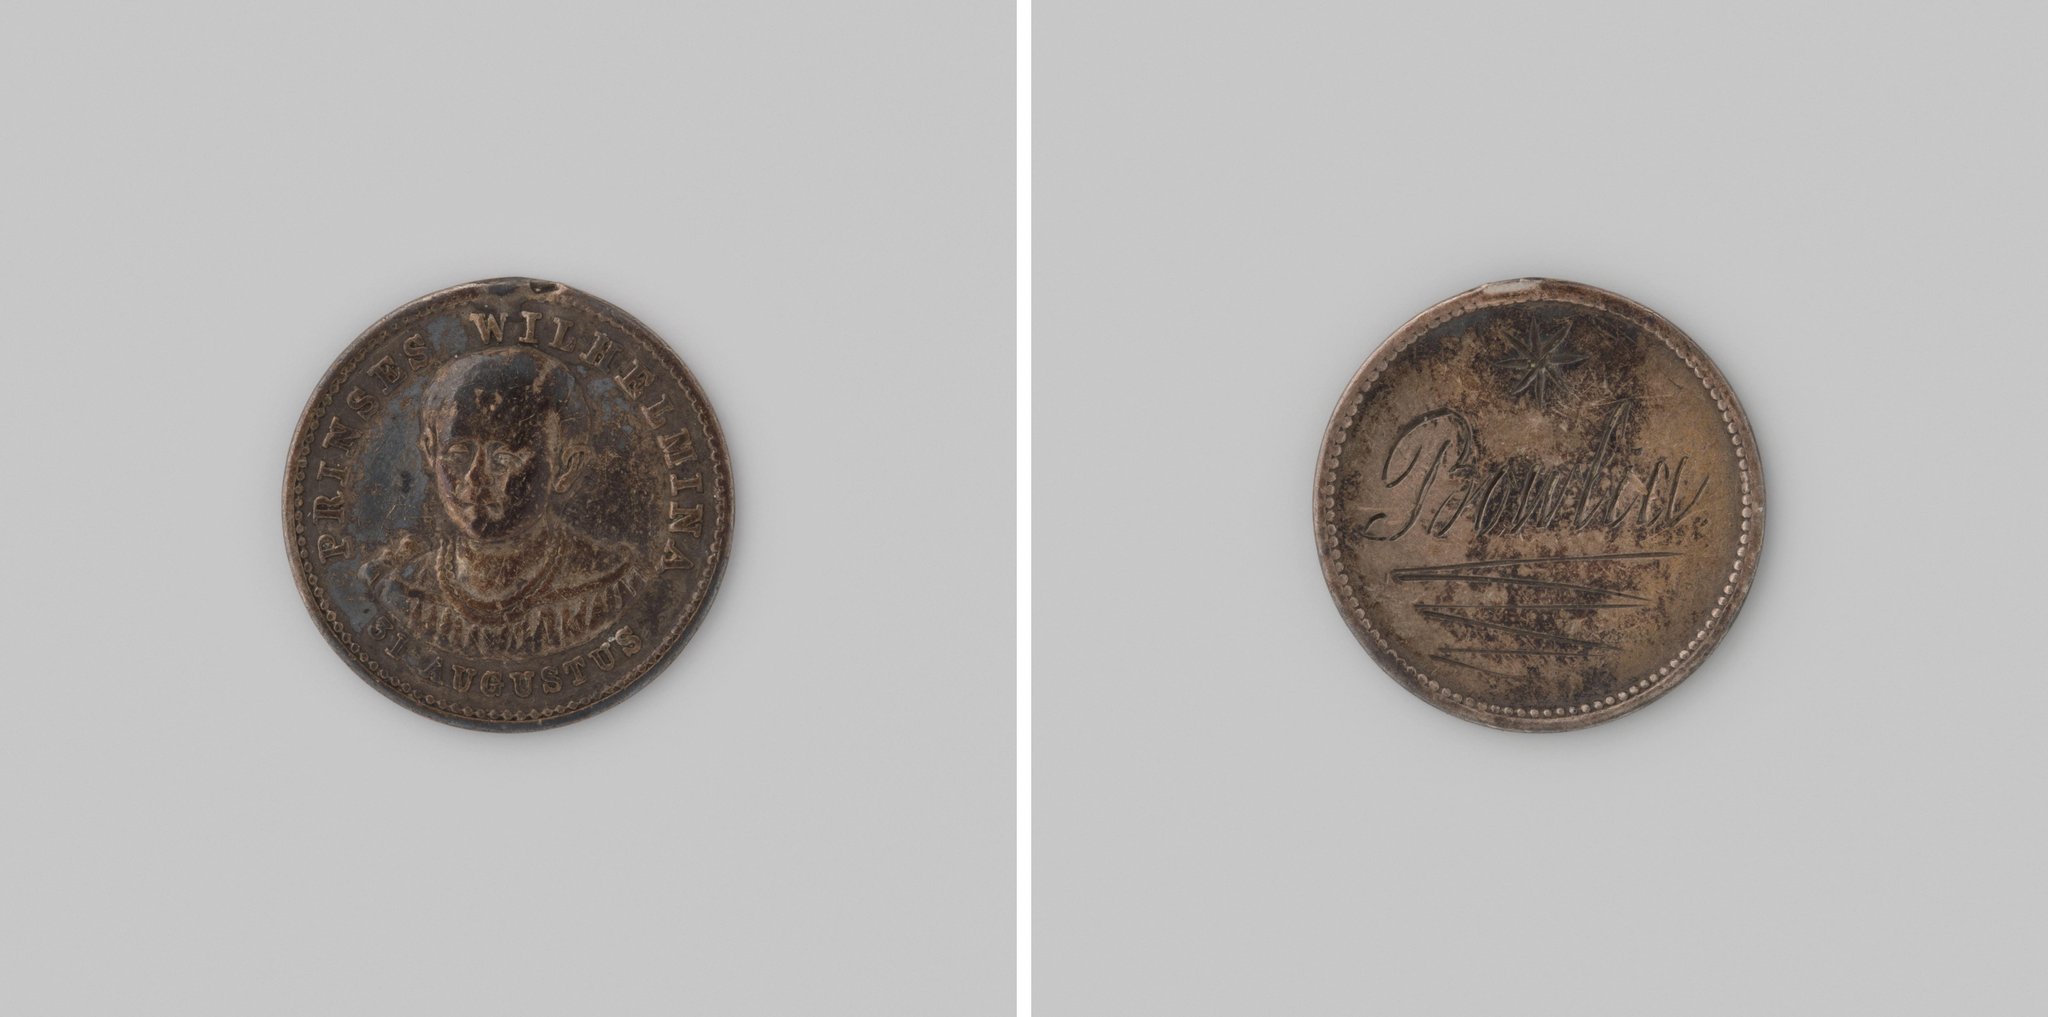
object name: history medal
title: Draagpenning op de vijfde verjaardag van Prinses Wilhelmina (1885) met inscriptie Bowlia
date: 1890-1898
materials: silver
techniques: engraving, striking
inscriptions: inscription: ‘(ster) / Bowlia. / (lijnen)’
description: Zilveren penning met verwijderd draagoog, op de voorzijde het borstbeeld van Wilhelmina half naar links met omschrift, de keerzijde glad met inscriptie Bowlia.